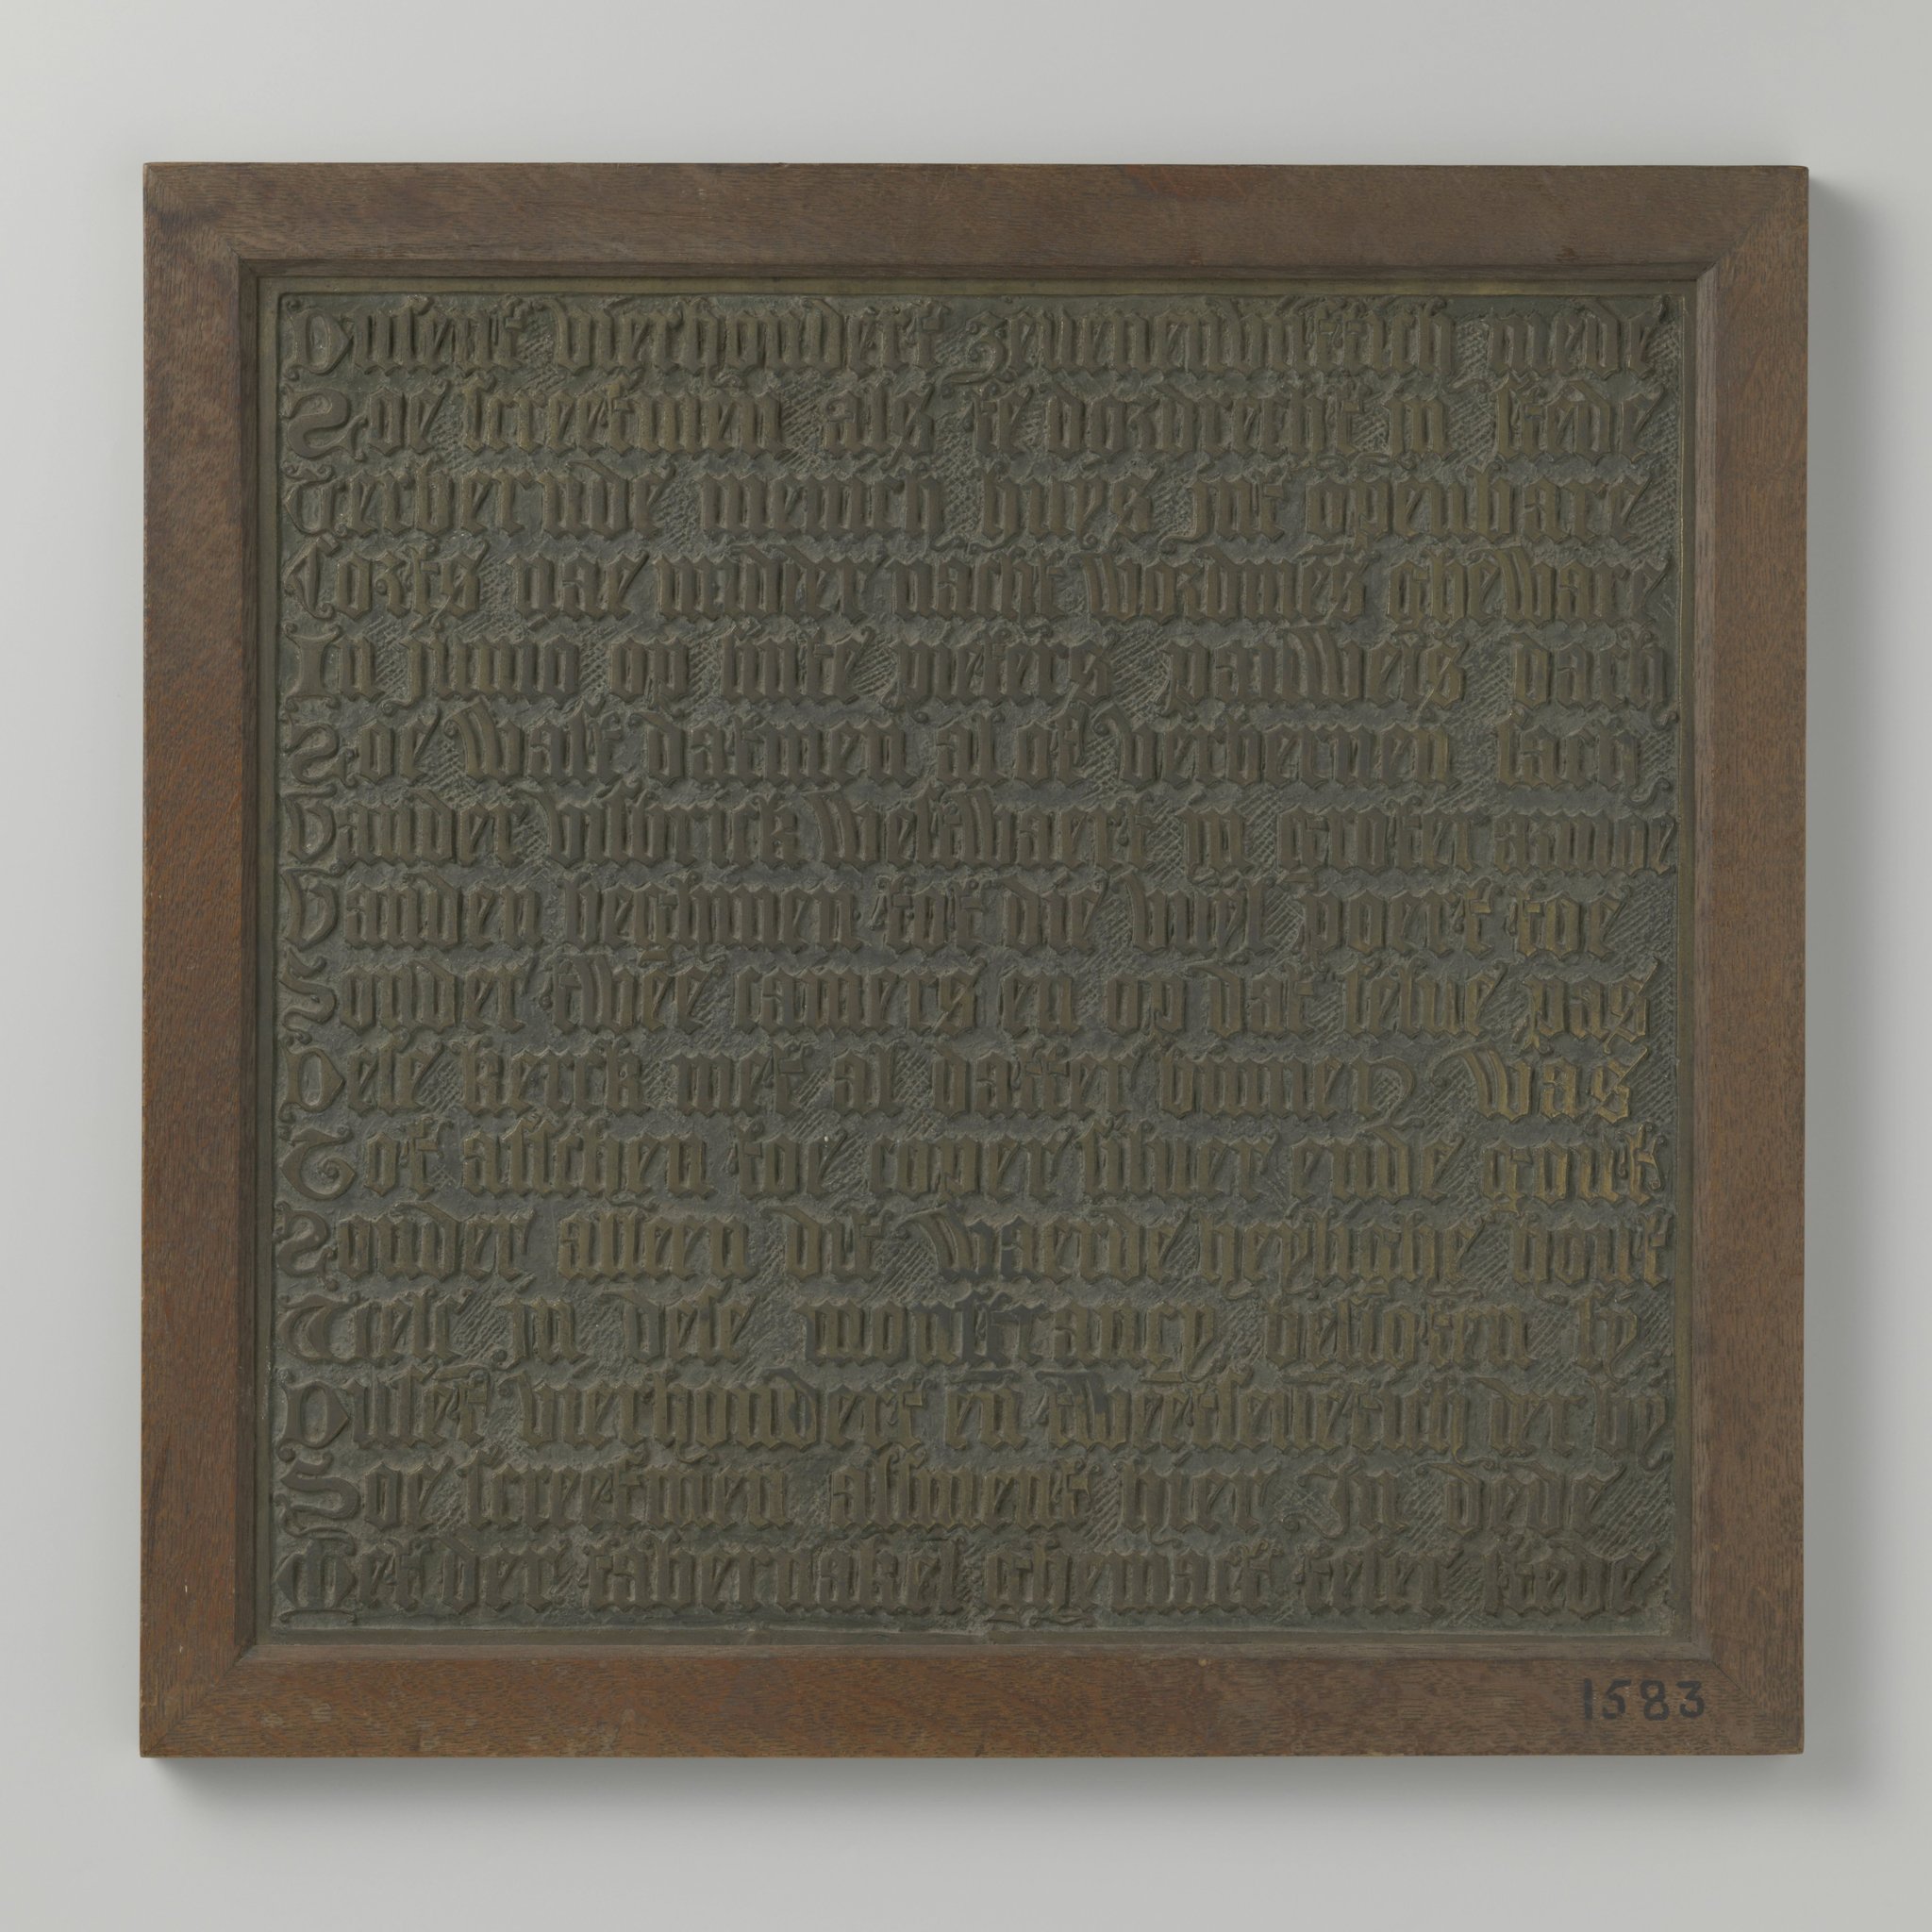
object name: plate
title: Plaat met tekst ter herinnering aan de brand van 1457 in de Grote Kerk te Dordrecht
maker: Anonymous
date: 1915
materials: brass, wood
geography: netherlands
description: Plaat van messing met tekst ter herinnering aan de brand van 1457 in de Grote Kerk te Dordrecht. Het geheel is gevat in een houten lijst.